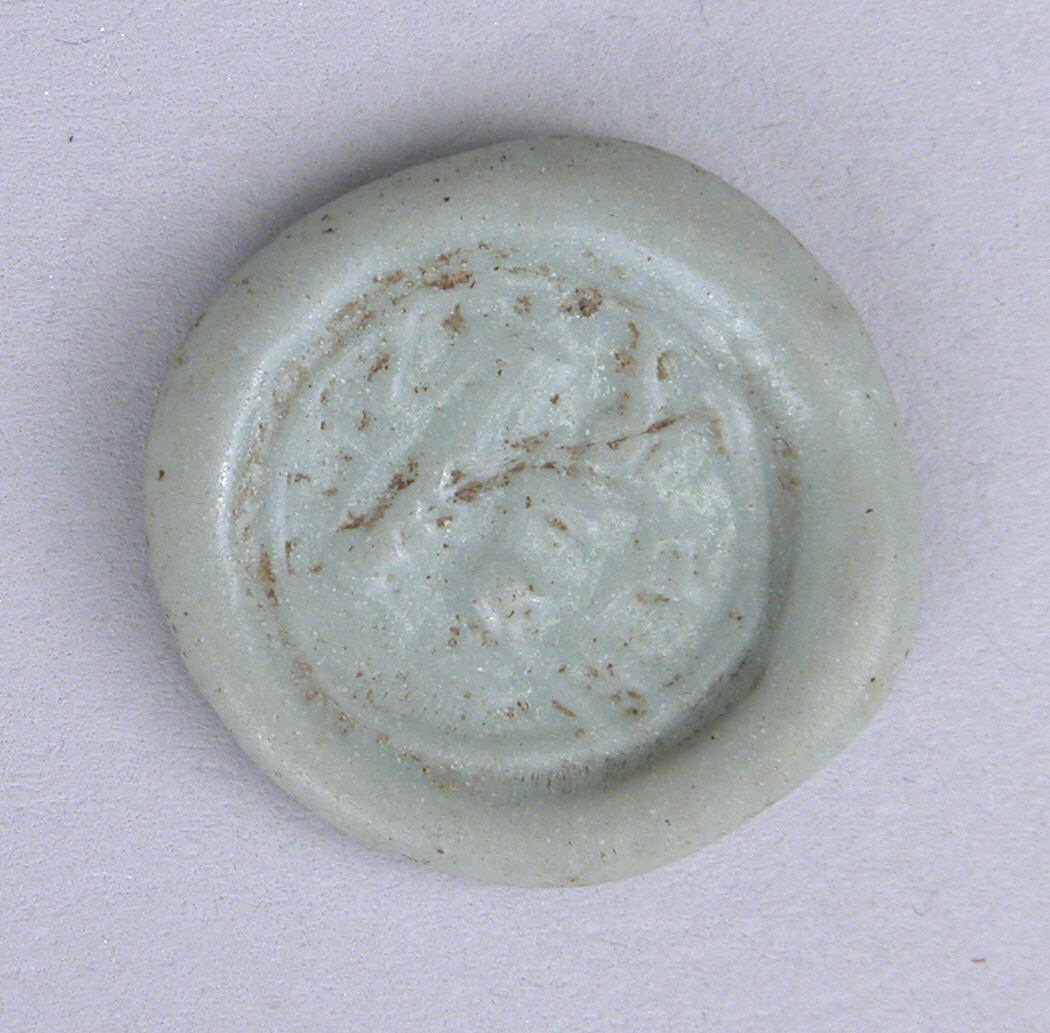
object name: coin weight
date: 1101-1200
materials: glass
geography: egypt